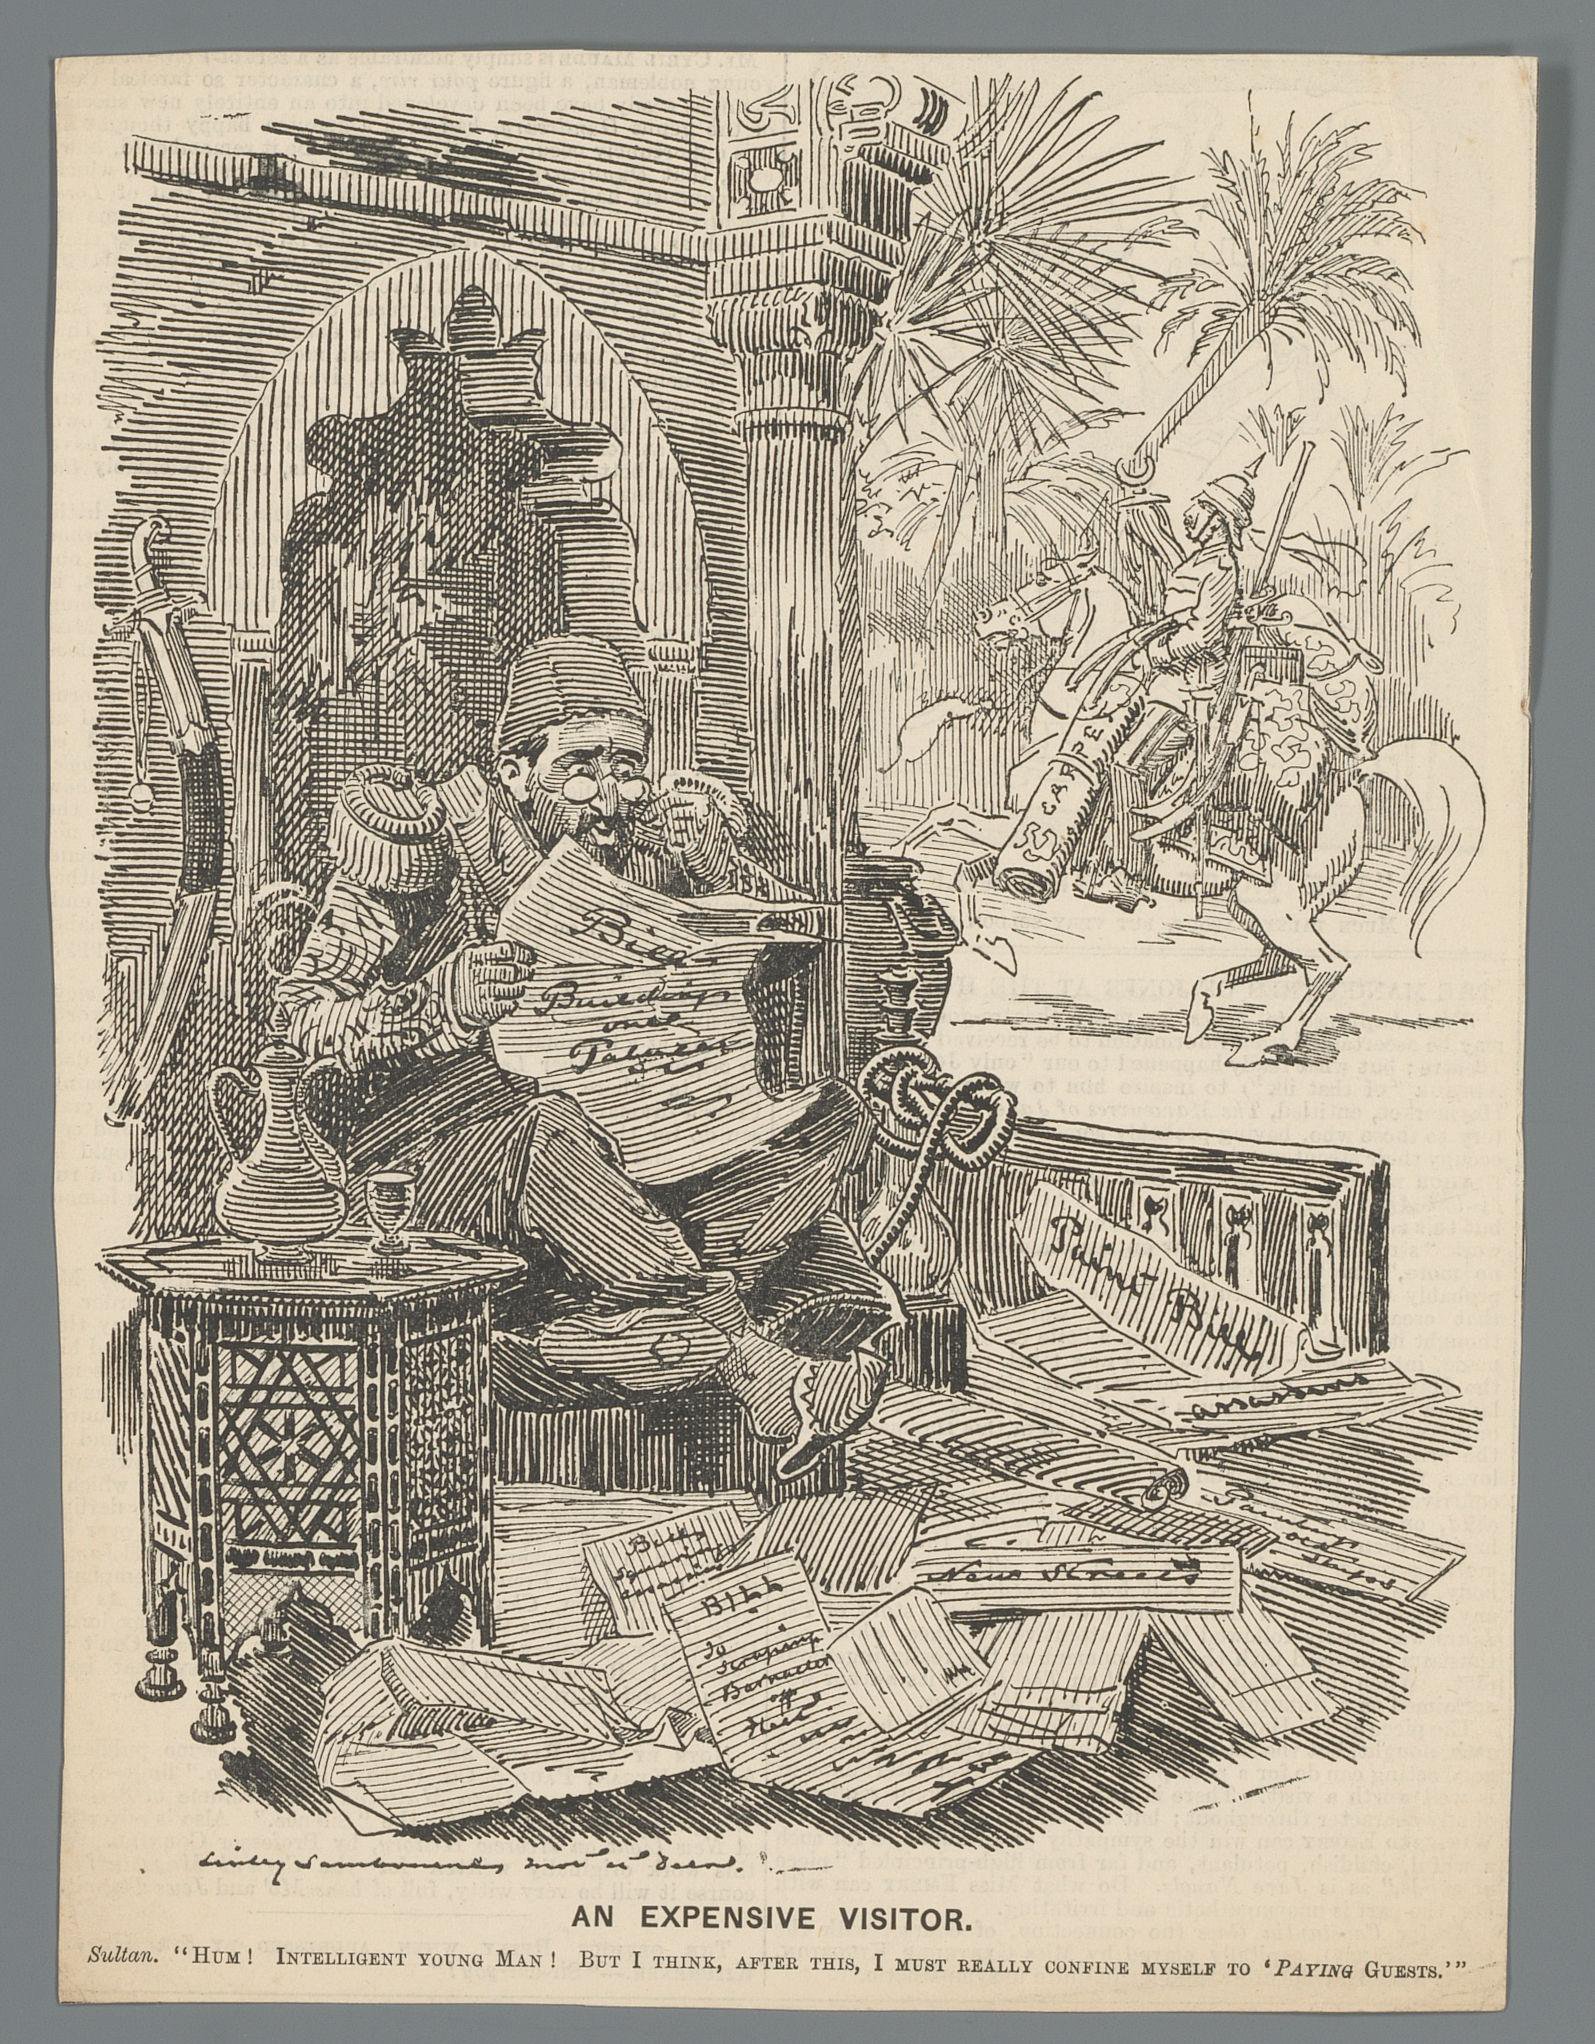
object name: print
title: De sultan en een dure Britse gast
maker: edward linley sambourne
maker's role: draughtsman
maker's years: 1844-1910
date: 1894-1904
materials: paper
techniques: line block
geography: england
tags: persons engaged in trade and commerce, political caricatures and satires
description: De sultan schrikt bij het zien van de hoge rekeningen na het bezoek van een Britse gast. Spotprent in het Engelse satirische tijdschrift Punch, ca. 1894-1904.